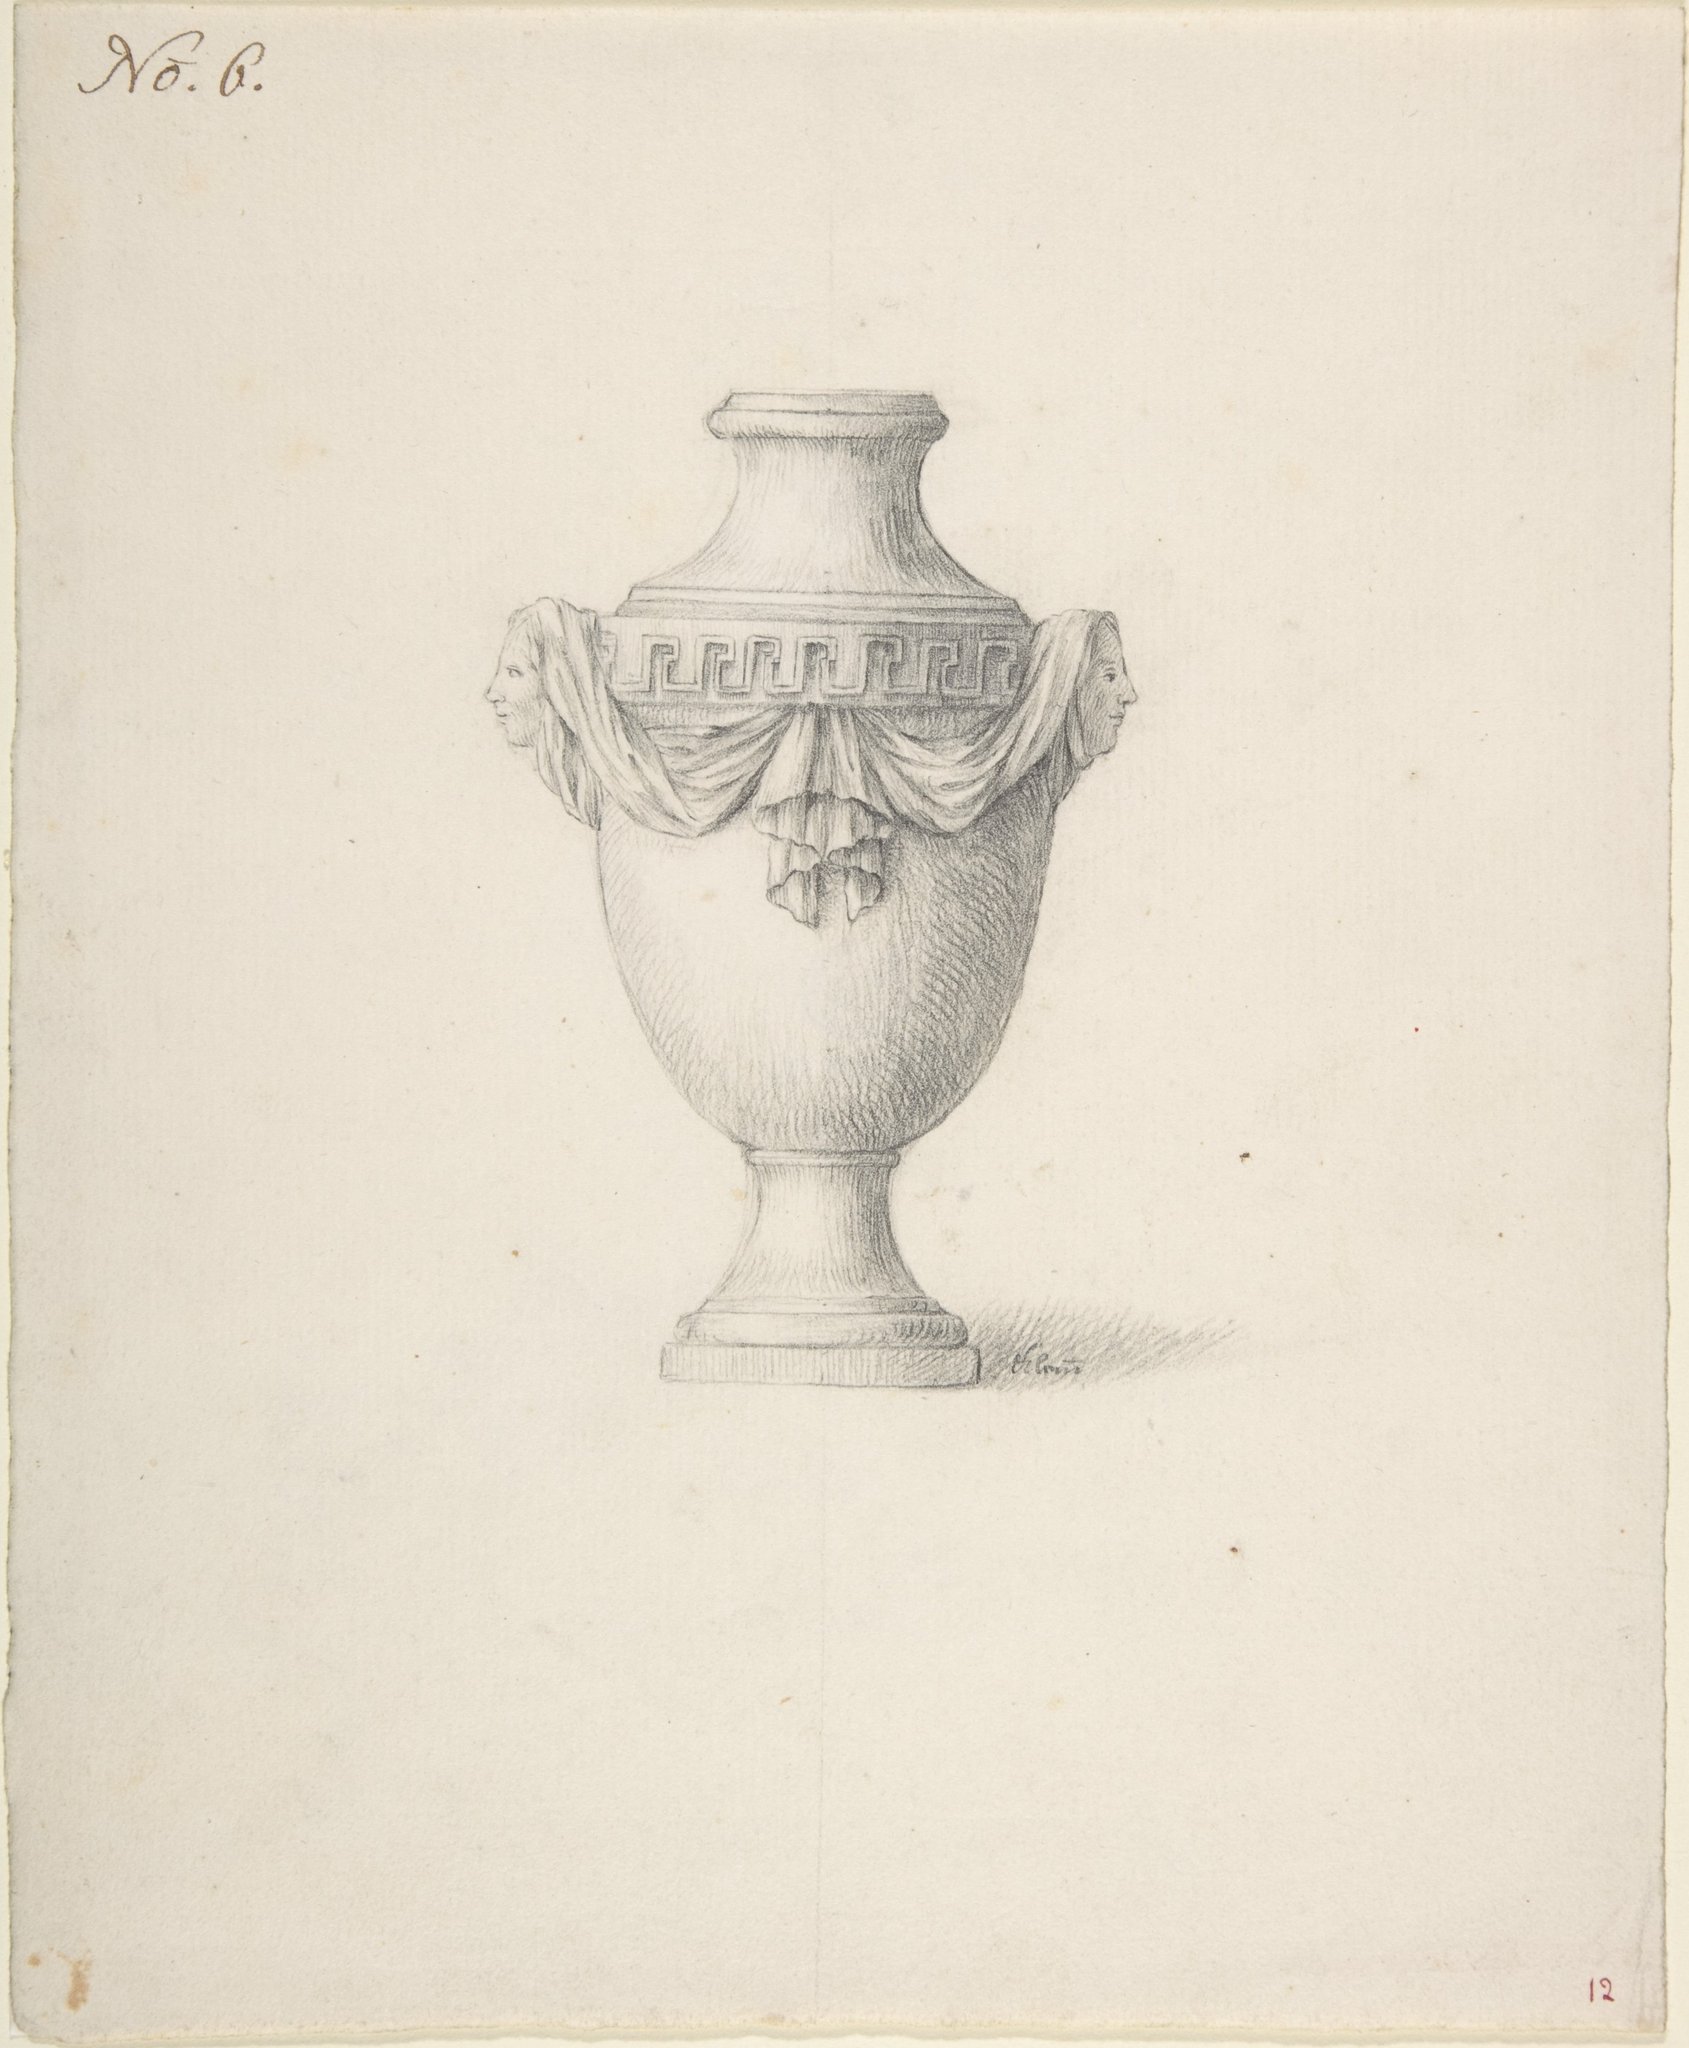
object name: drawing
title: Design for an Urn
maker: anonymous, french, 18th century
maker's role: artist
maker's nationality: french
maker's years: 1700-1800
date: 1770-1790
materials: graphite, ink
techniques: pen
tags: heads,urns